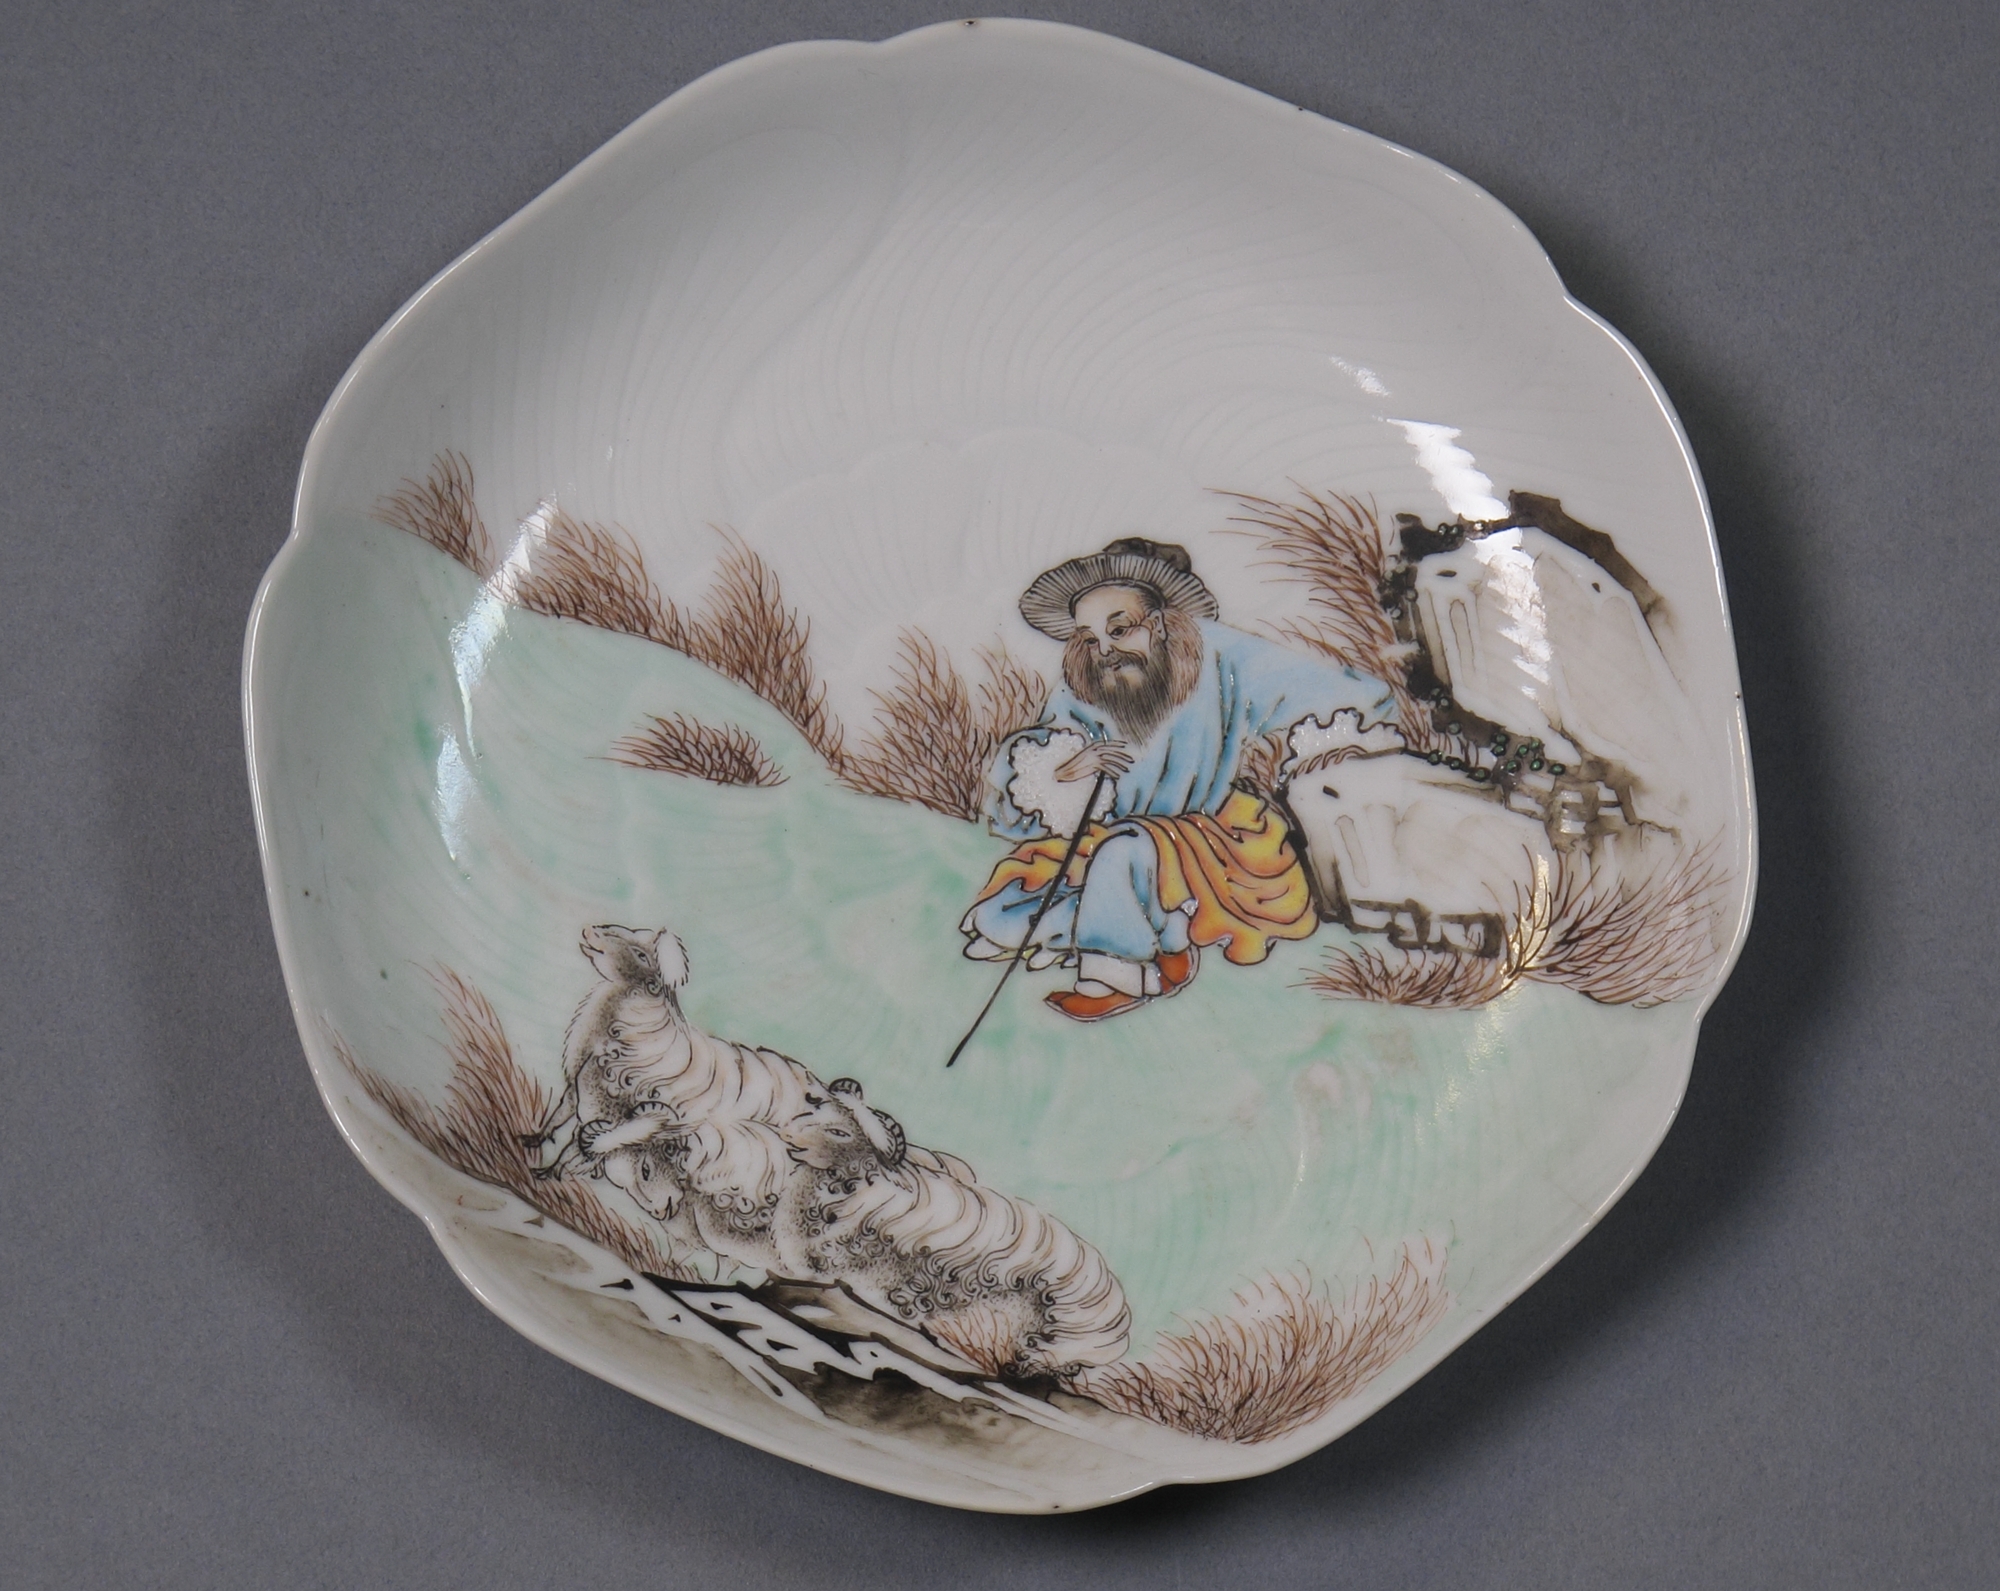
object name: saucer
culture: chinese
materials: enamel, porcelain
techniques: molding, overglaze, painting, polychrome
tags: men,sheep